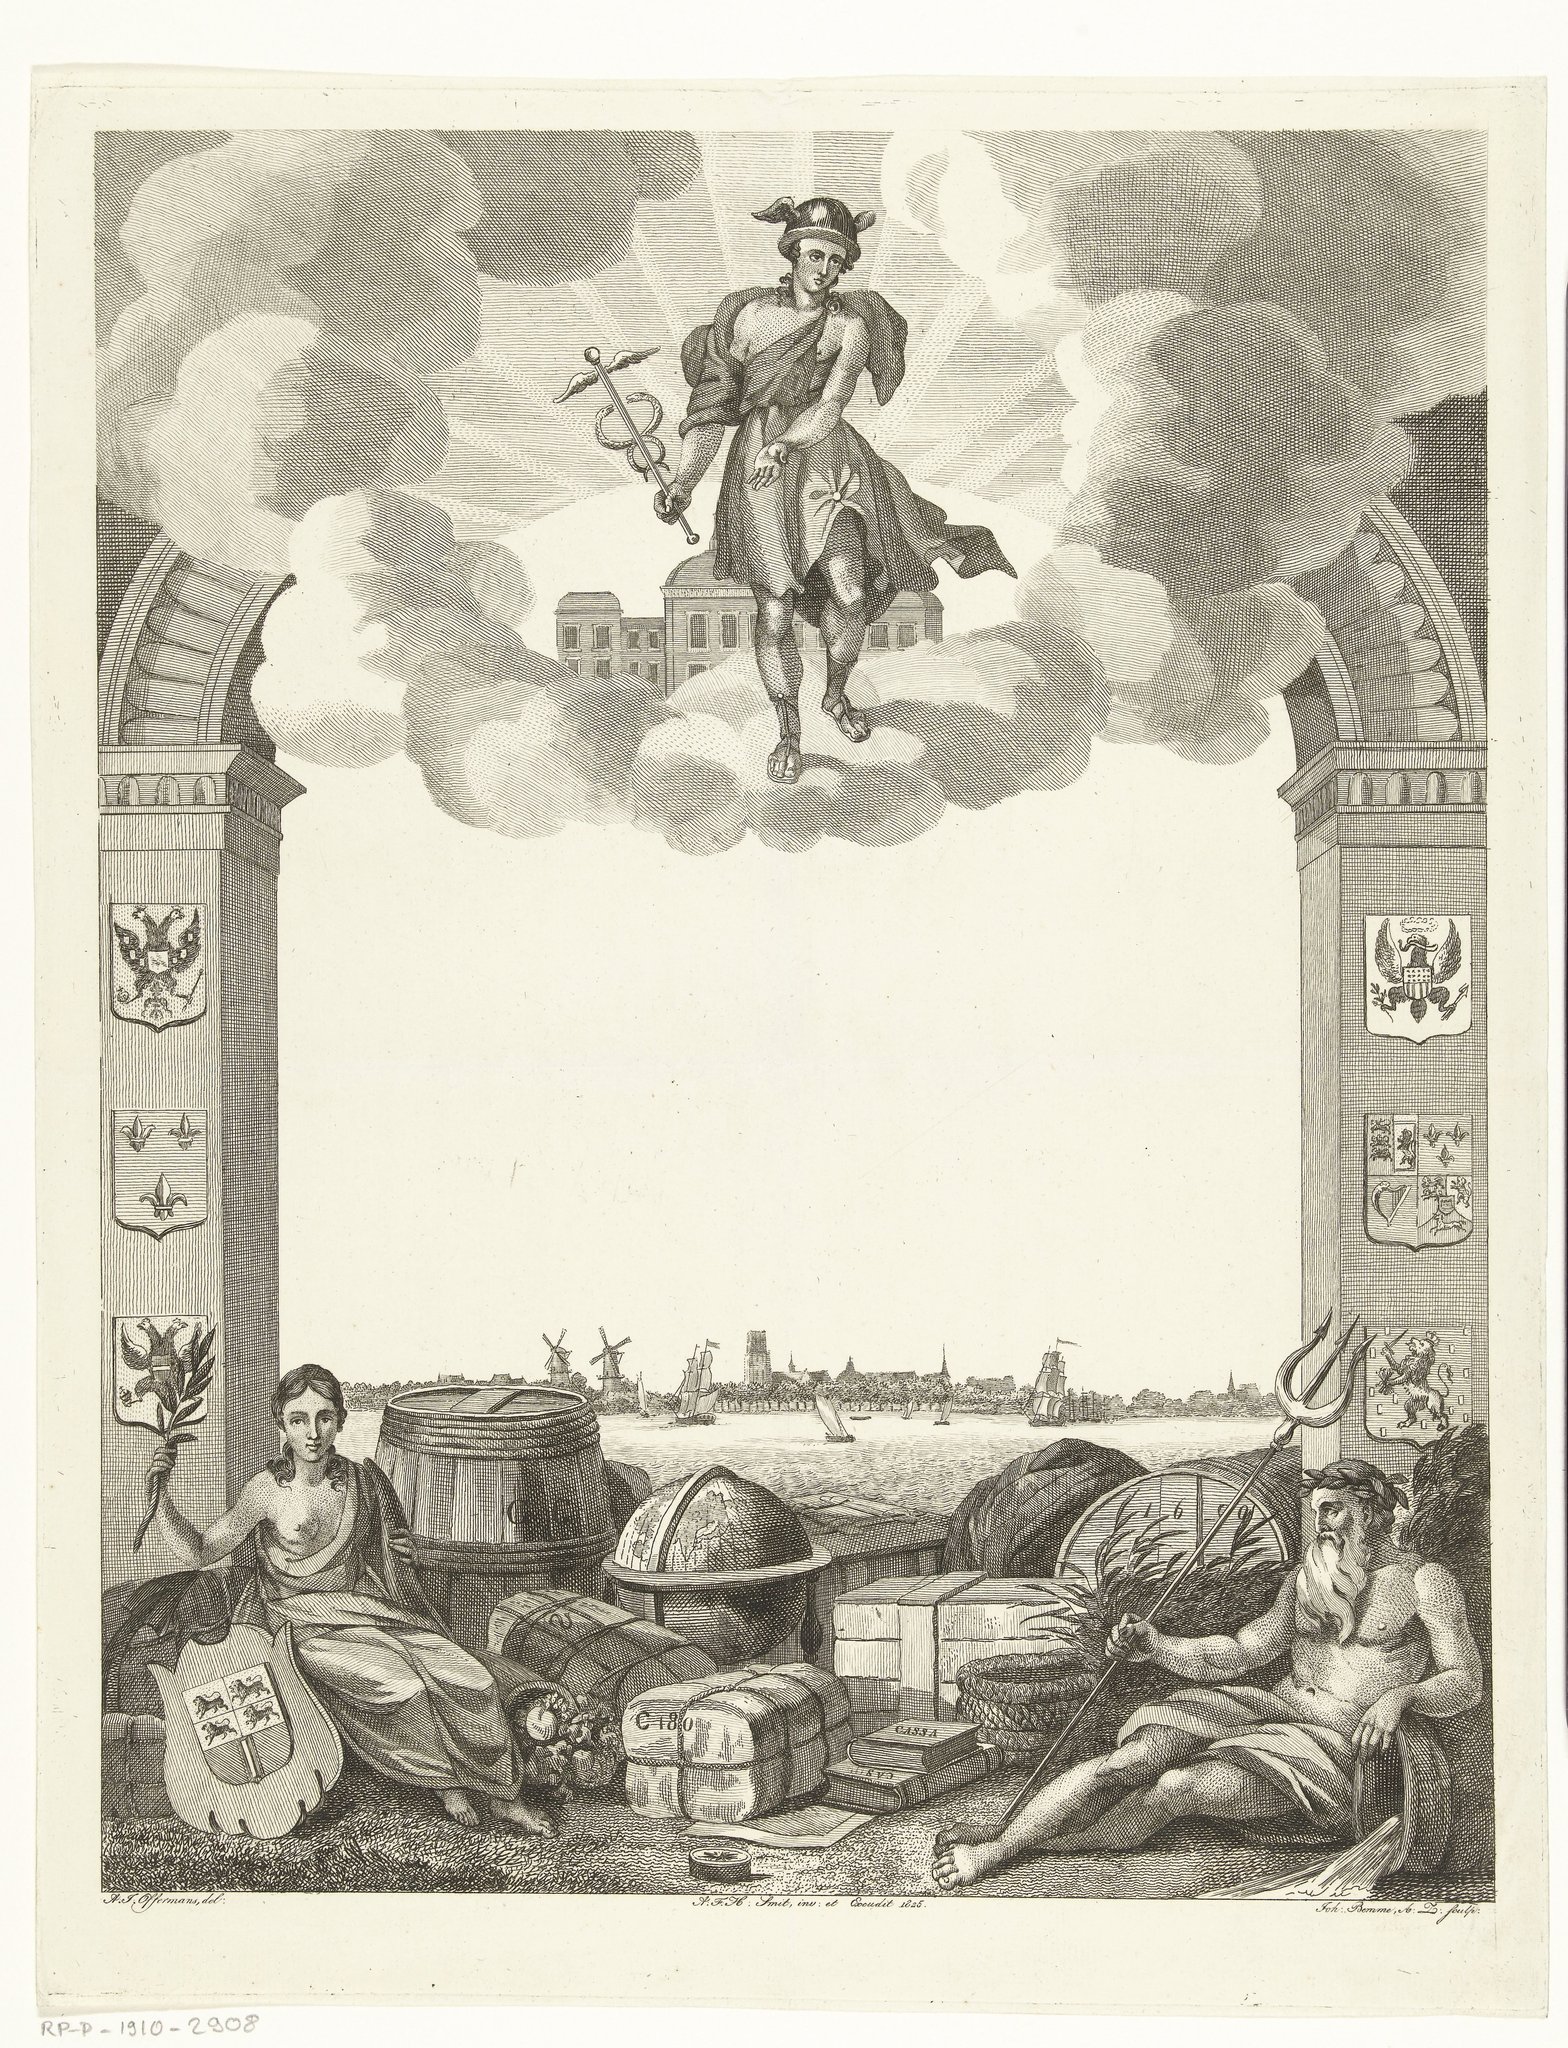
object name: print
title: En Hollande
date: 1851-1910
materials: paper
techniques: etching, intaglio, letterpress printing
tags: sailing-ship, sailing-boat, dordrecht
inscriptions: collector's mark: Lugt 2228